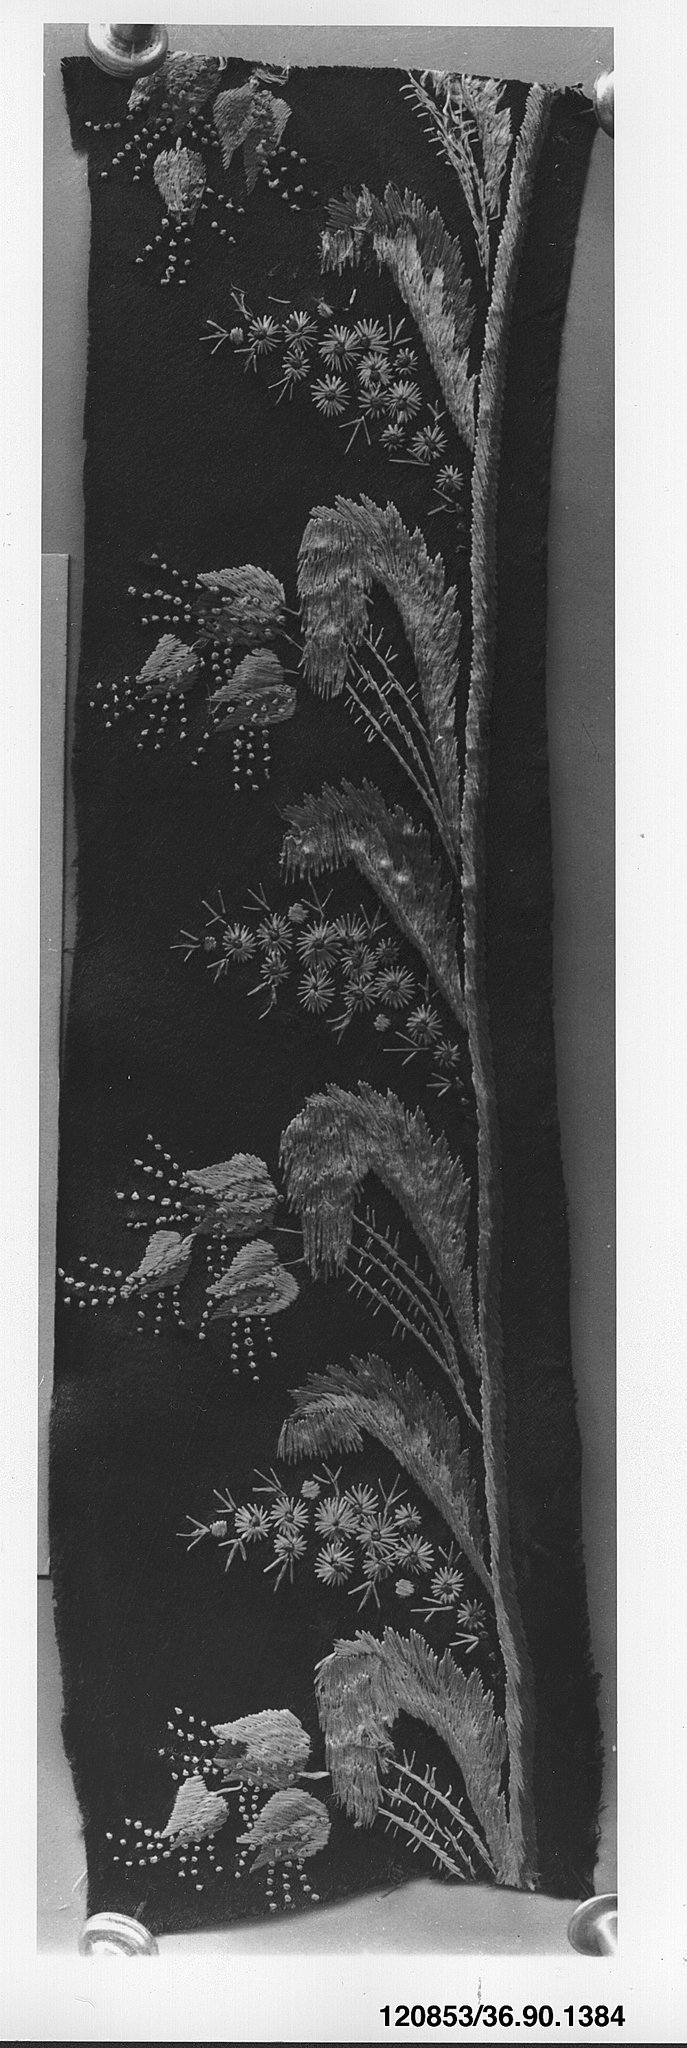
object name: piece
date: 1801-1833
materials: silk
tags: flowers,leaves